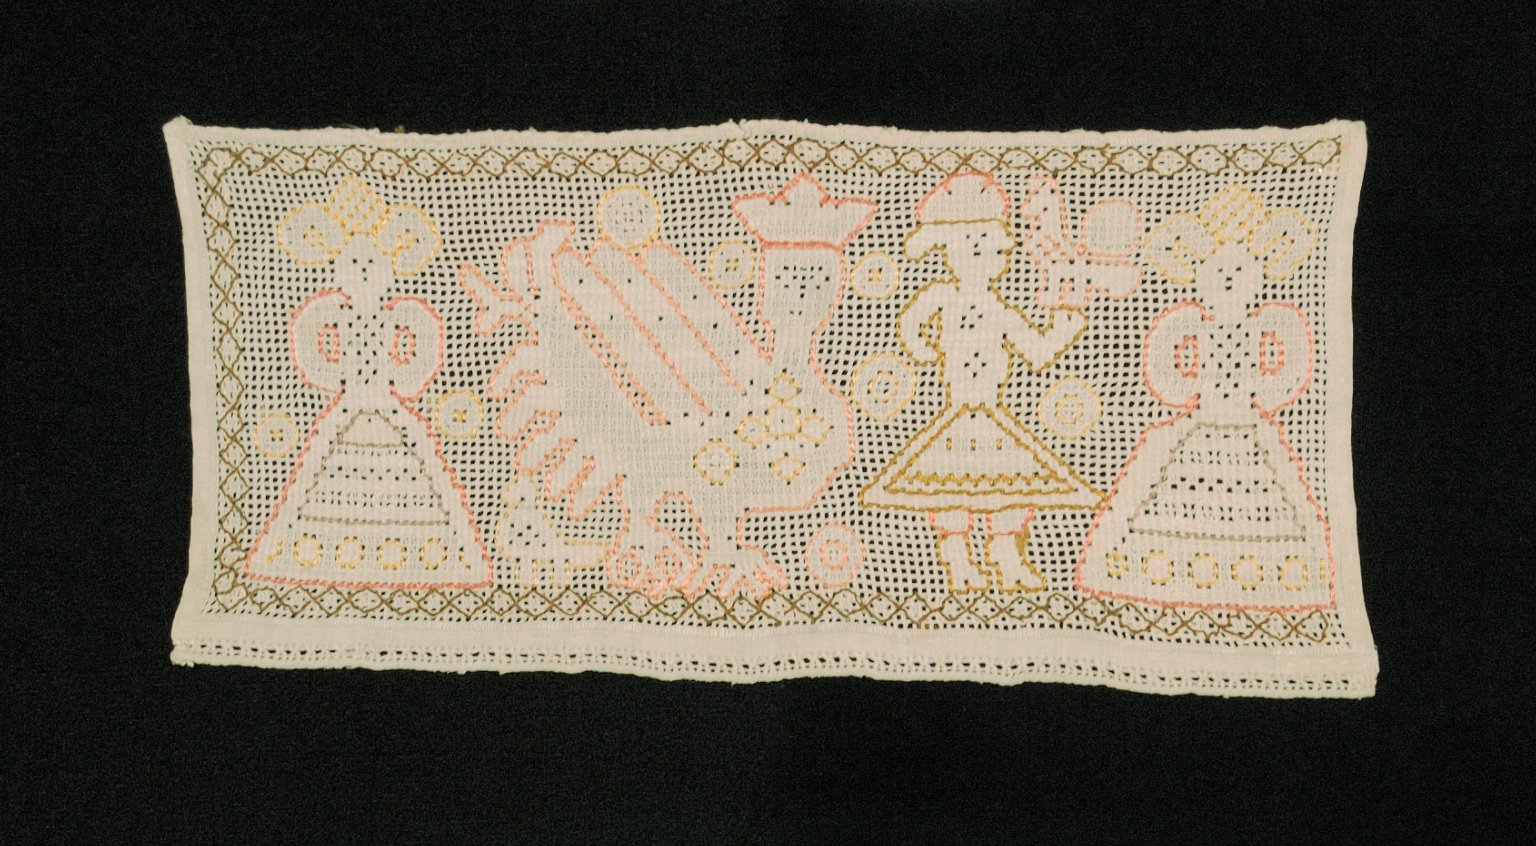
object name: border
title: Towel border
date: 1800-1850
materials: linen, silk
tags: birds,men,women